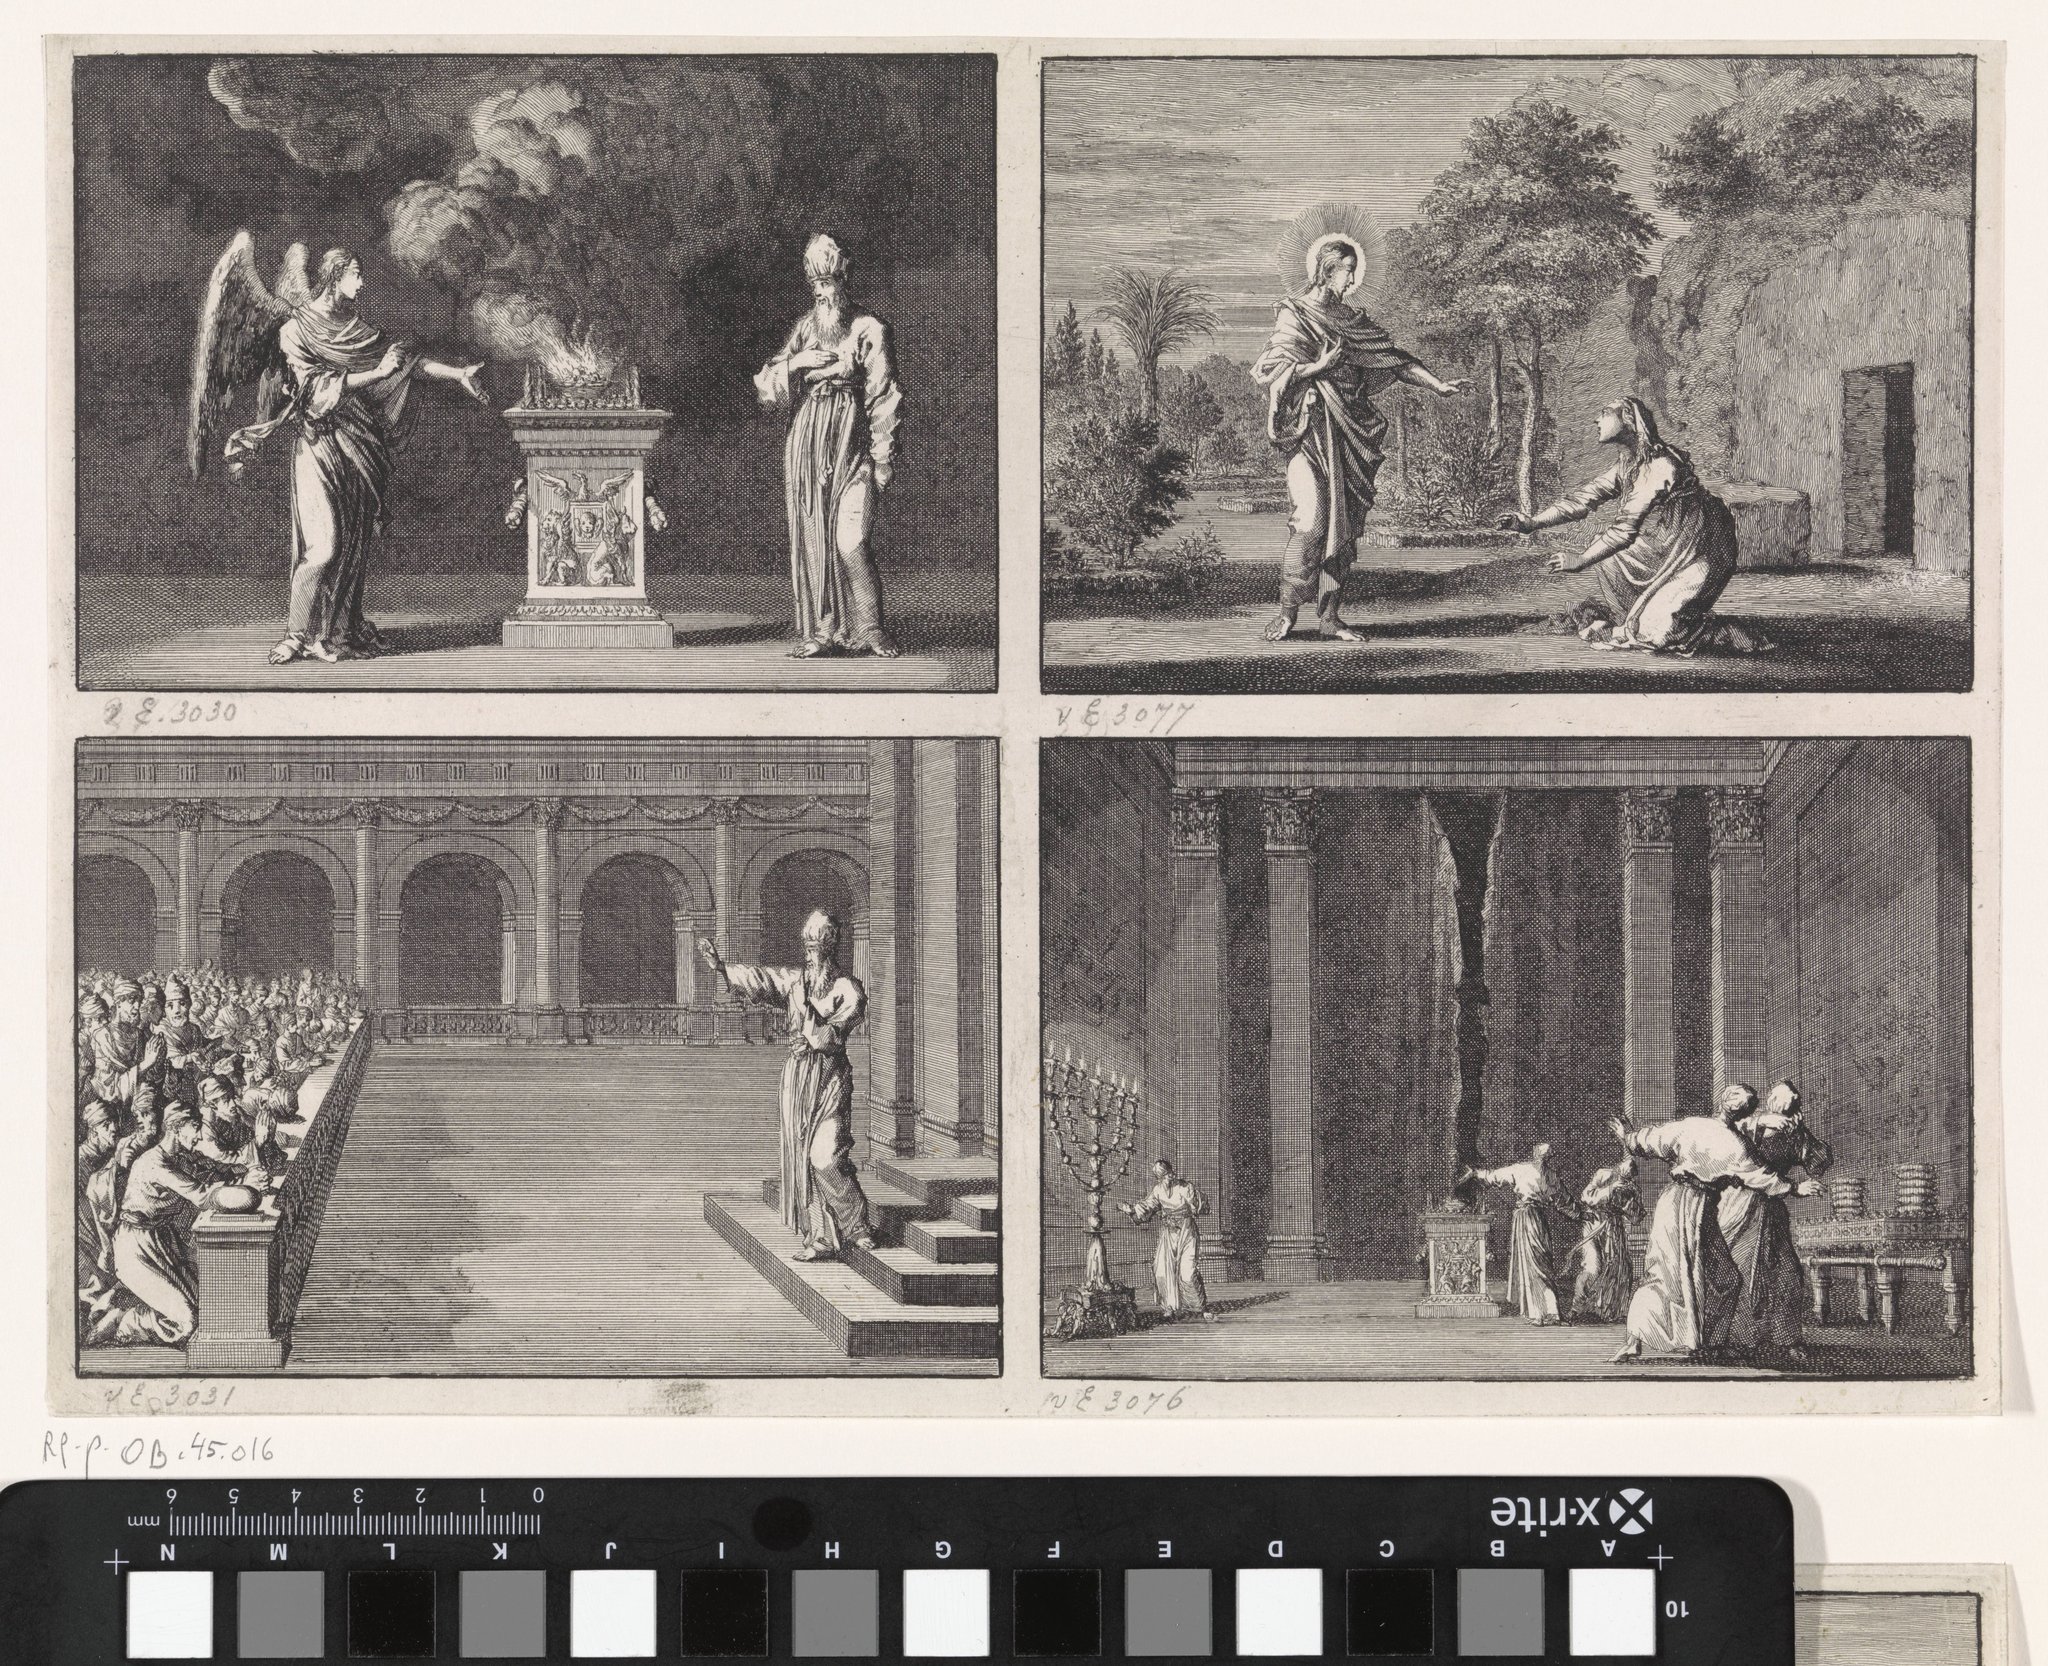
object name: print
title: Vier voorstellingen uit het Nieuwe Testament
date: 1703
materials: paper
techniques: etching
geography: haarlem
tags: the rending of the veil of the temple ~ christ's death, mary magdalene kneeling before christ, who is usually represented as a gardener with a hoe and/or a spade; 'noli me tangere', zacharias speechless before the people, annunciation of the birth of john the baptist to zacharias: while he is offering incense in the temple an angel (gabriel) appears to him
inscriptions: collector's mark: Lugt 2228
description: Proefdruk van boekillustraties voor David Martin. Historie des Ouden en Nieuwen Testaments. Amsterdam, Pieter Mortier, 1703. Deel II. De boekillustraties voor de Mortierbijbel hebben verschillende staten en kopieën, waarbij de chronologische volgorde moeilijk te achterhalen valt. Als boekillustraties werden ze bovendien herhaaldelijk opnieuw gebruikt voor andere boekwerken.